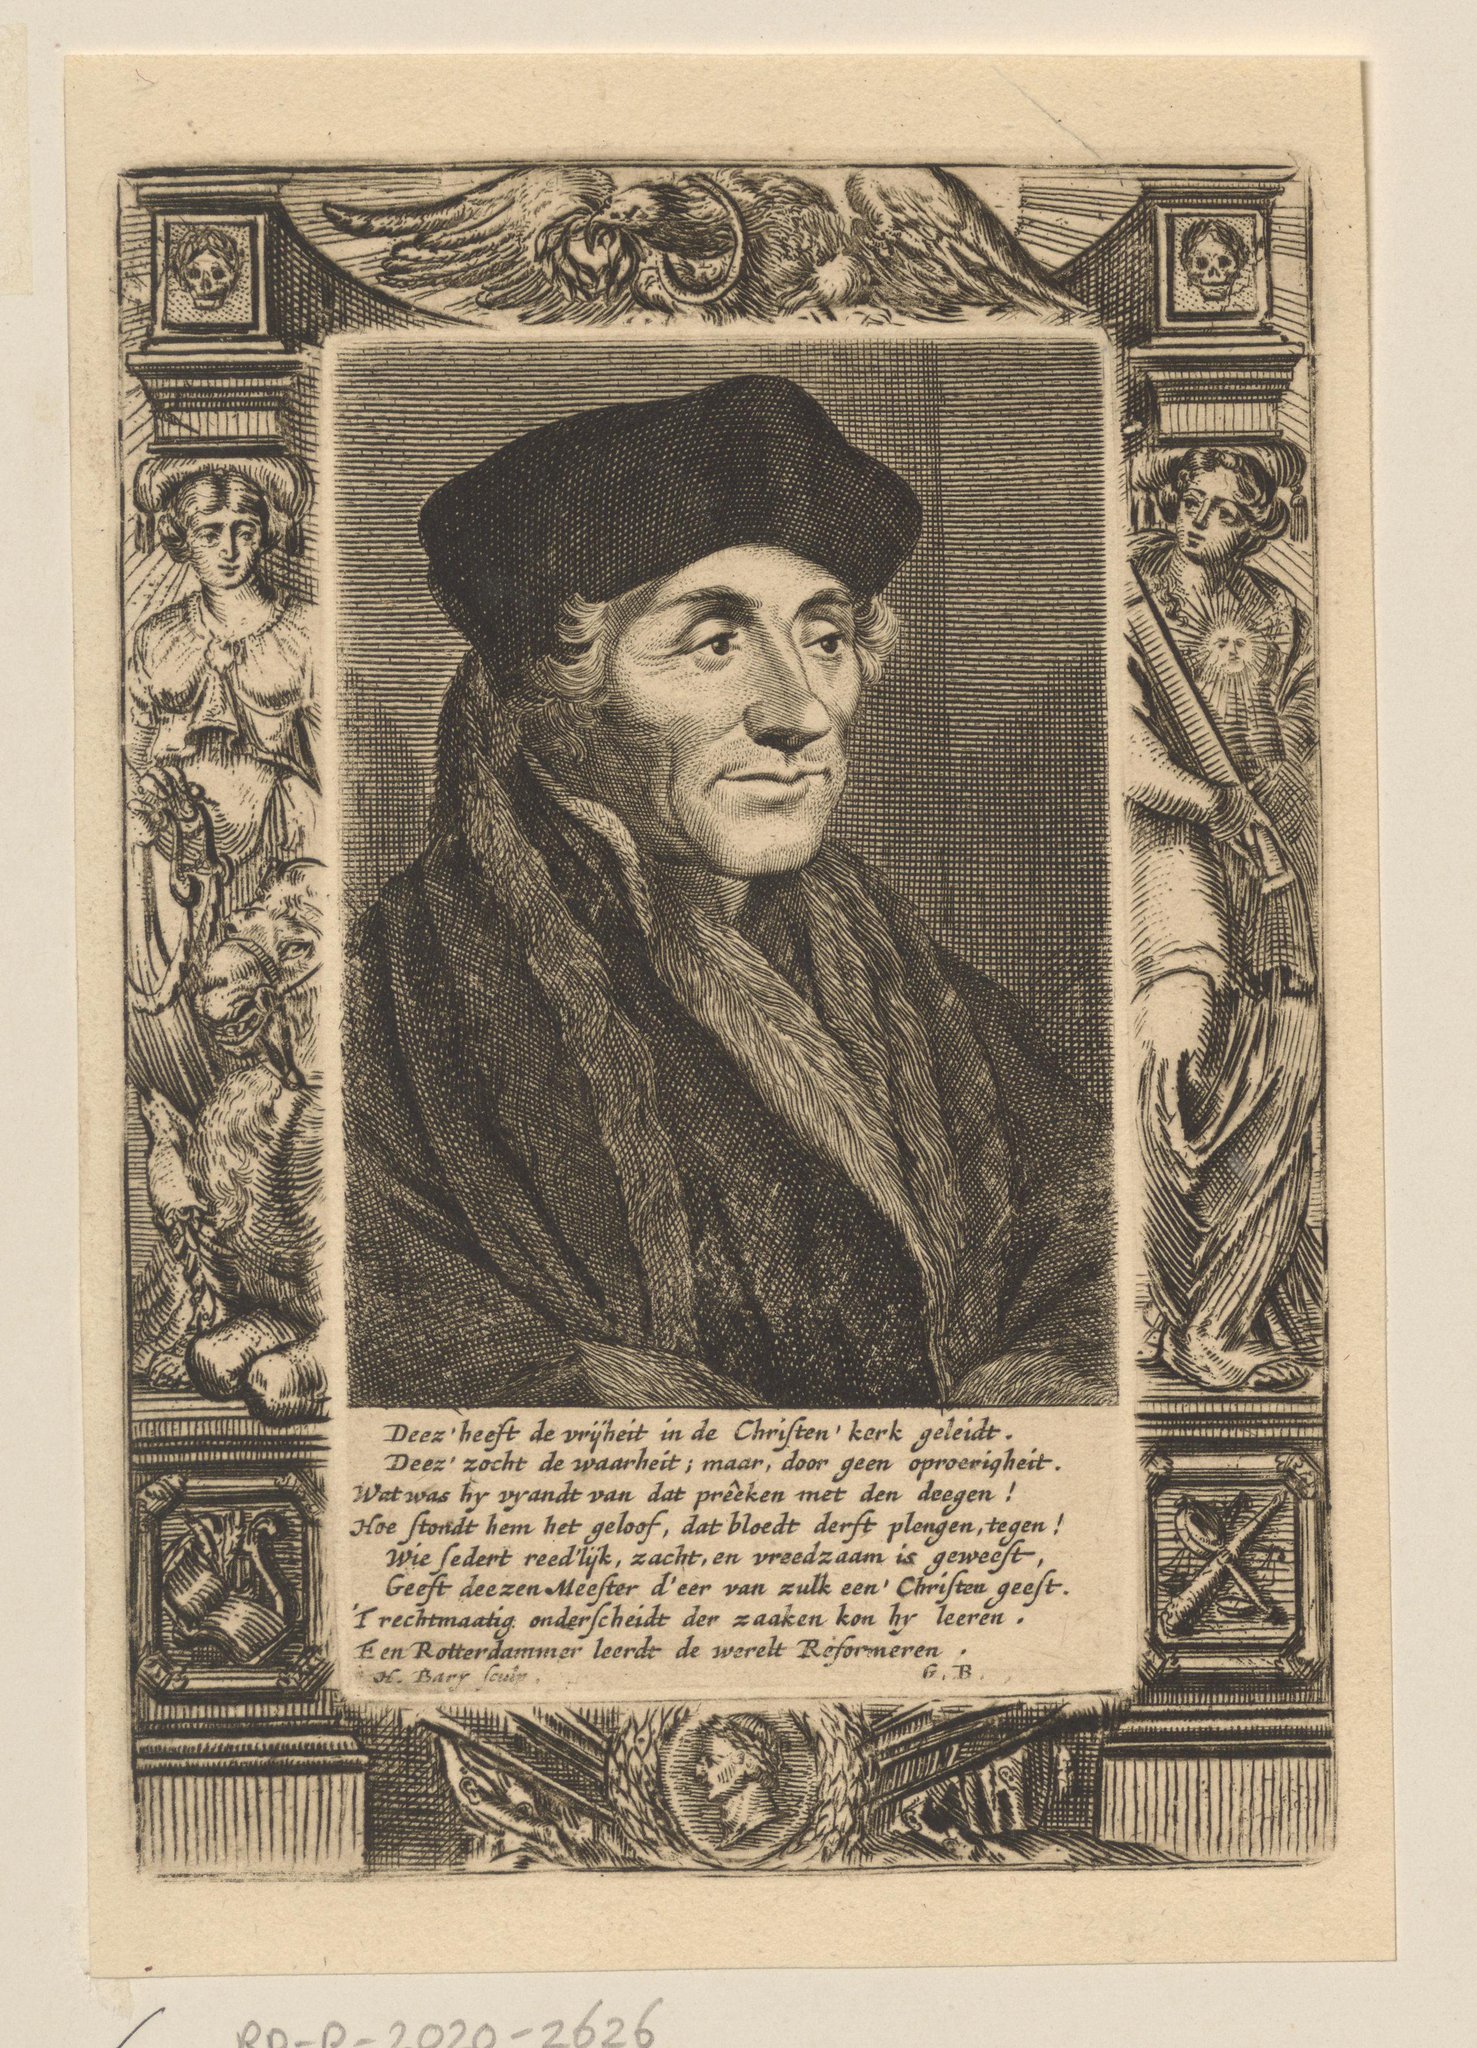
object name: print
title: Portret van Desiderius Erasmus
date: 1671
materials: paper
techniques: engraving, etching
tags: rotterdam, desiderius erasmus, hoofed animals: camel, historical persons, scholar, philosopher (+ portrait of scholar, scientist)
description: Prent met omlijsting in eerste staat en portret zonder omlijsting gebruikt in: G. Brandts Historie der Reformatie (...). Amsterdam: Jan Rieuwertsz., Hendrik en Dirk Boom, 1671. Prent in deze staat met deze omlijsting mogelijk gebruikt in een andere druk van 'Historie der Reformatie'.